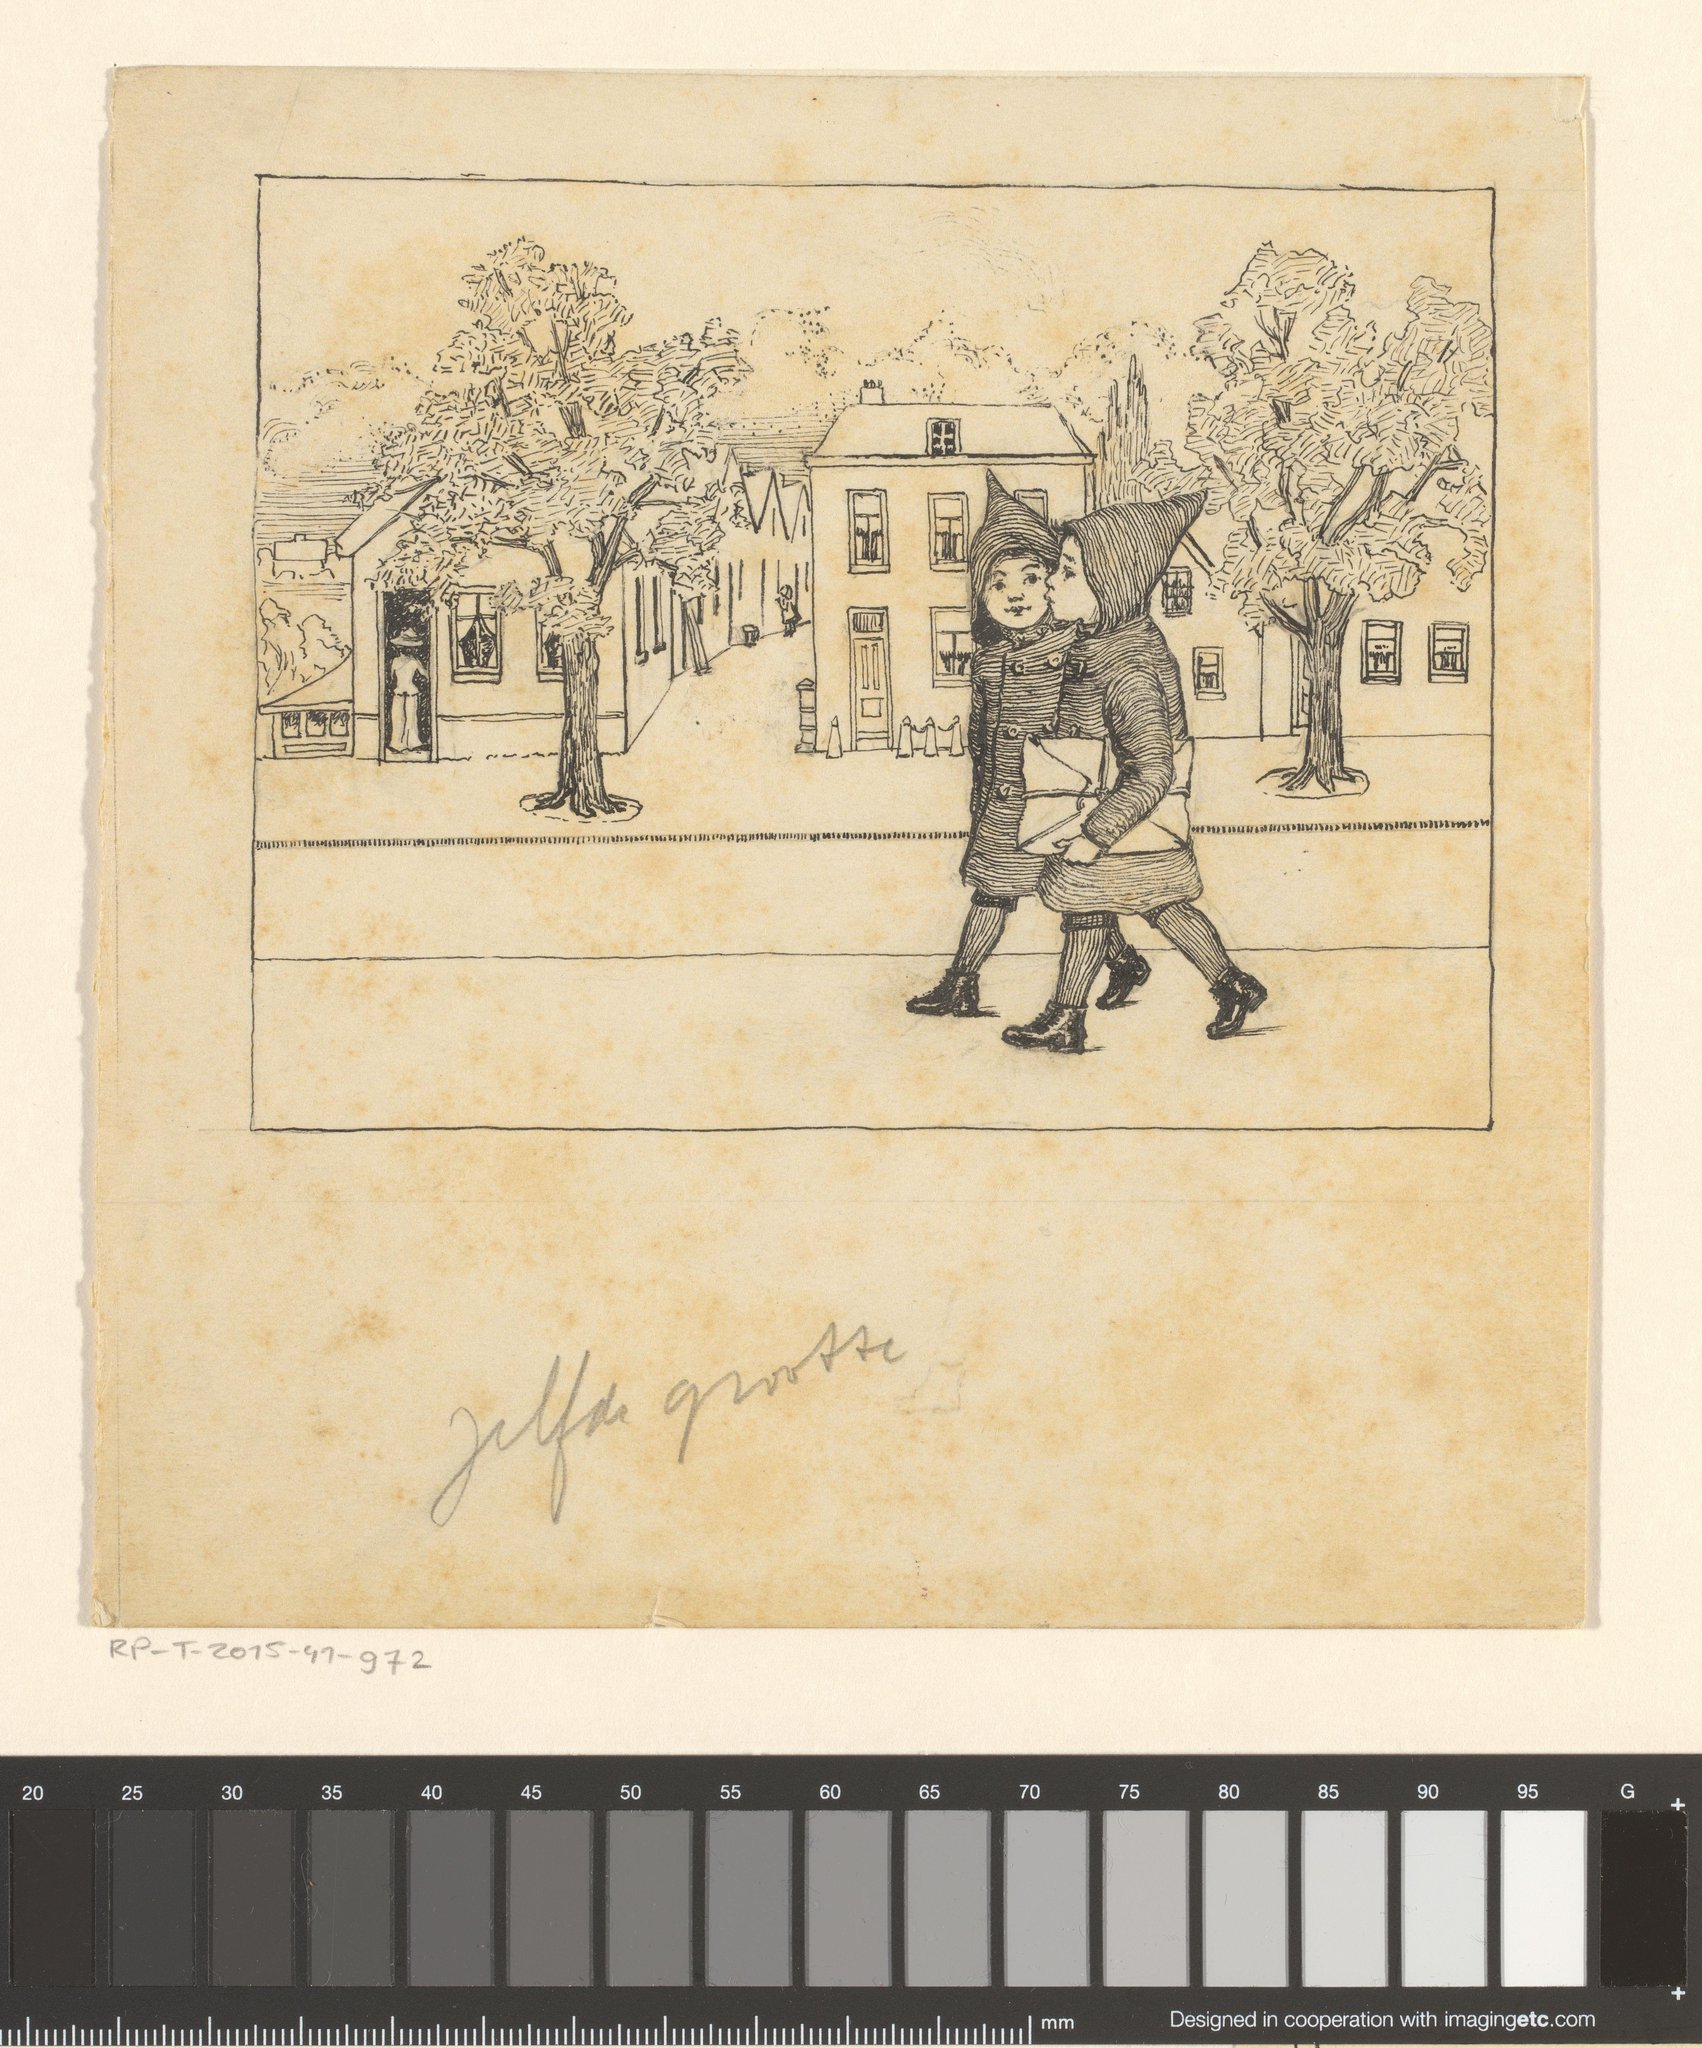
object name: drawing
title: Twee wandelende kinderen met een pakket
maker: adri ladenius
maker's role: draughtsman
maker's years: 1883-1953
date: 1893-1953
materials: ink, paper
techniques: pen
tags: parcel, packet, street (+ city(-scape) with figures, staffage)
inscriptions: collector's mark: Lugt 2228, :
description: Twee kinderen in jassen met puntmutsen lopen over een straat. Eén van de twee heeft een pakket onder de arm.